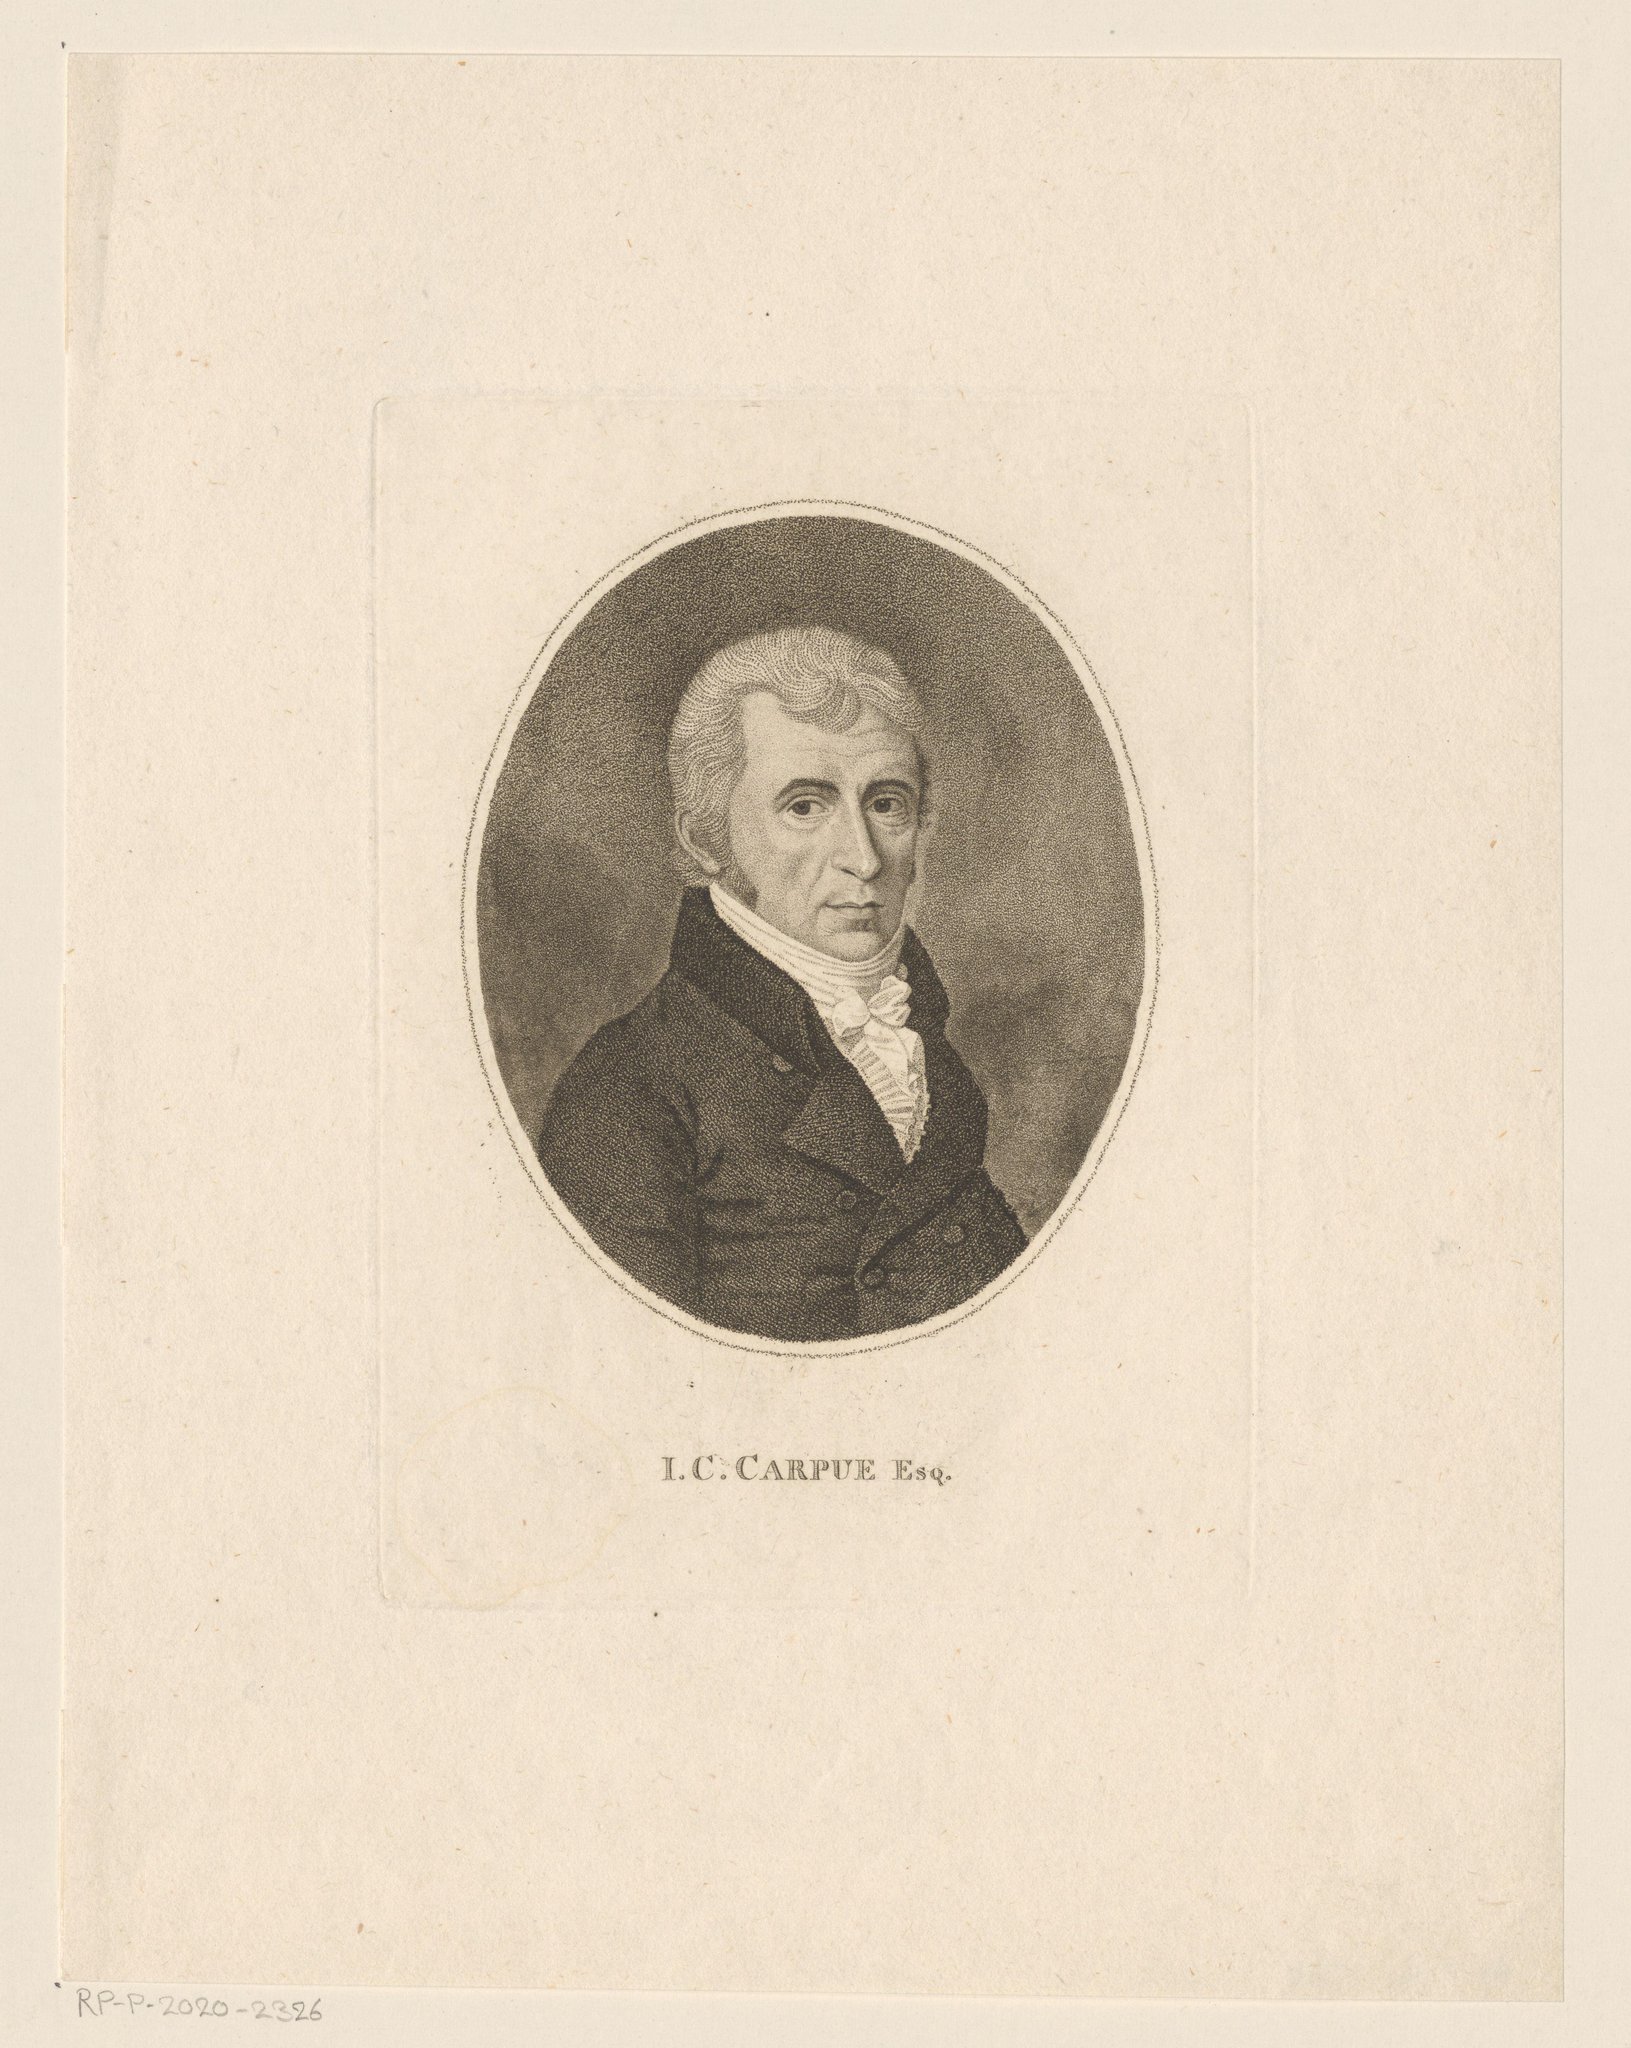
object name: print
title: Portret van Joseph Constantine Carpue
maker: Anonymous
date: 1800-1849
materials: paper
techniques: engraving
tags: london, historical persons